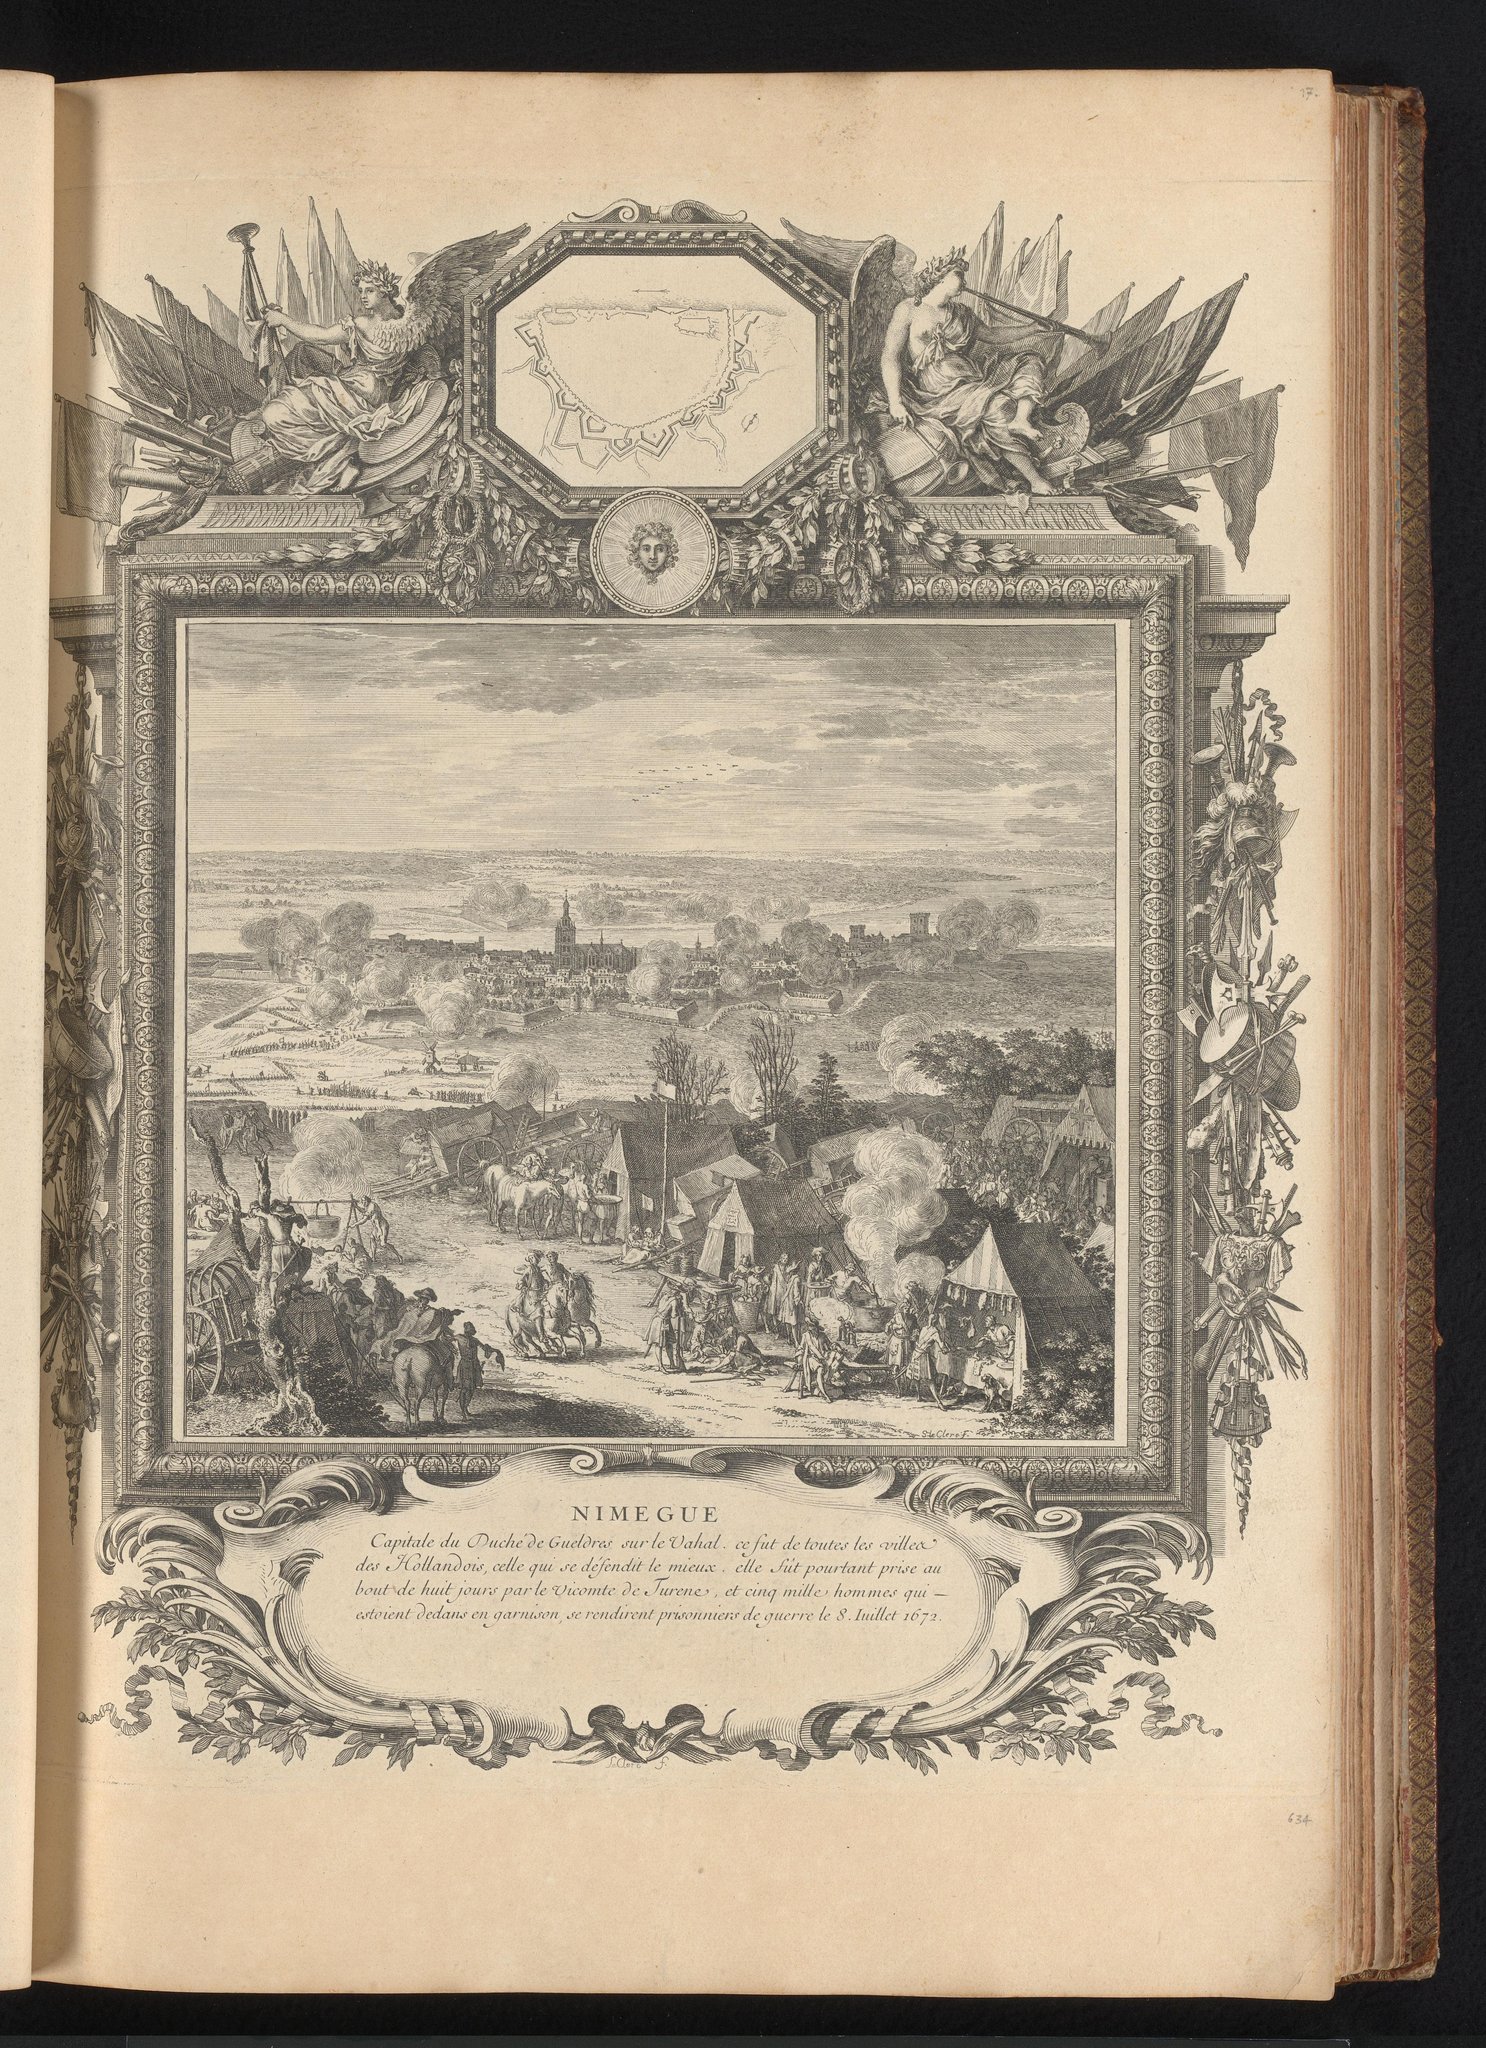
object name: print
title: Inname van Nijmegen, in een cartouche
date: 1694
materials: paper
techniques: engraving, etching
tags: capture of city (after the siege), nijmegen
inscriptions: watermark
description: Maakt deel uit van een serie bestaande uit 28 prenten met oorlogstaferelen in ornamentele cartouches. De prenten zijn gedrukt van twee afzonderlijke platen bestaande uit de voorstelling en de cartouche.